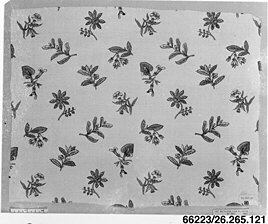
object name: piece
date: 1785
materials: linen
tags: flowers,leaves